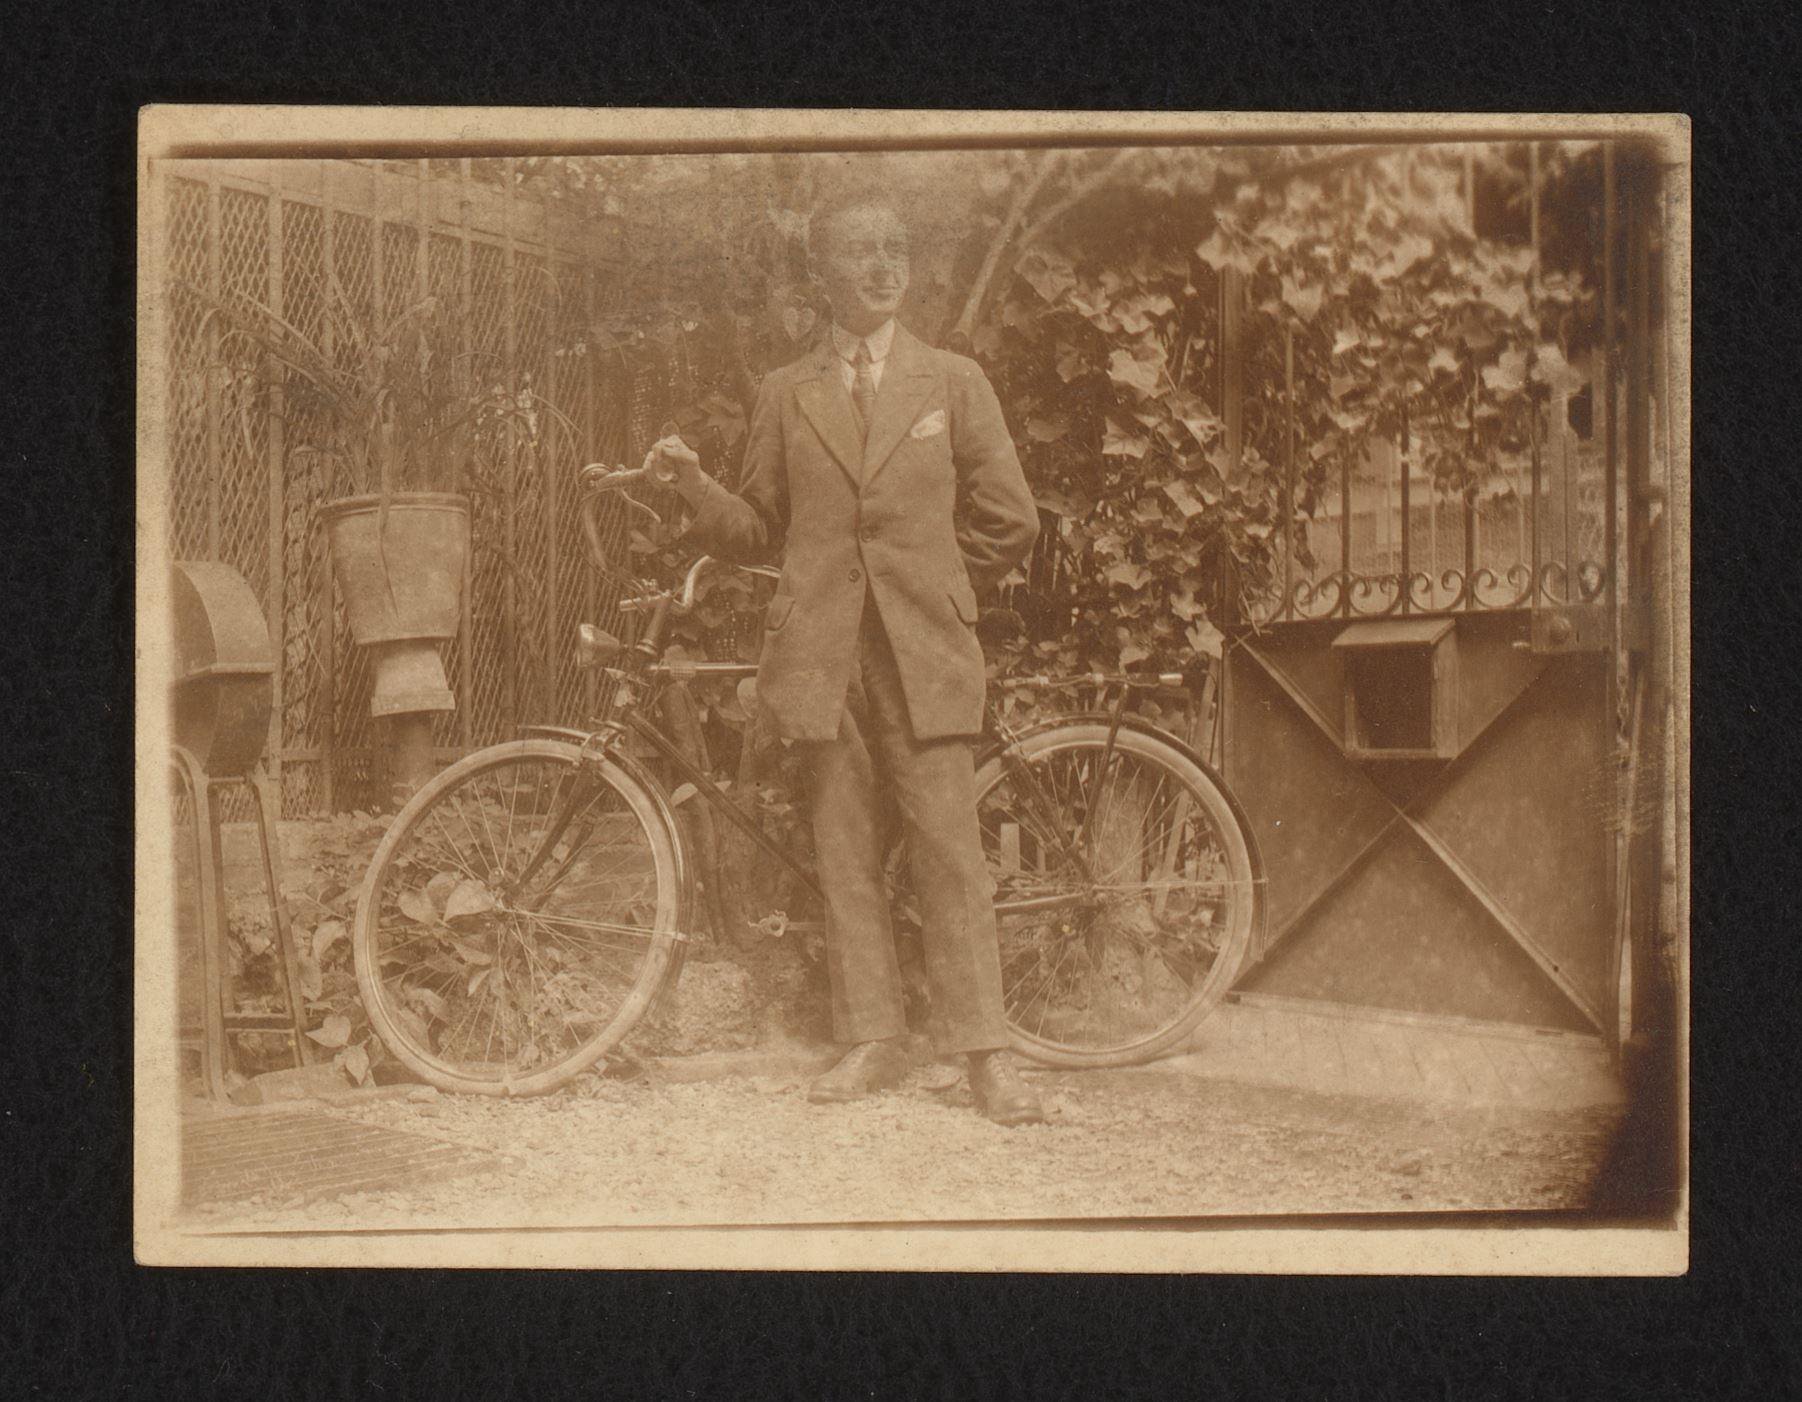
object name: photograph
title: Portret van een man met een fiets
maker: Anonymous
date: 1880-1920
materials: cardboard, photographic support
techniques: collodion silver print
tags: adult man, historical persons, bicycle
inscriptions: annotation: ‘qui? I don't care/ c'est [...] le jardin du 24/ V. E. Meyer [...]’